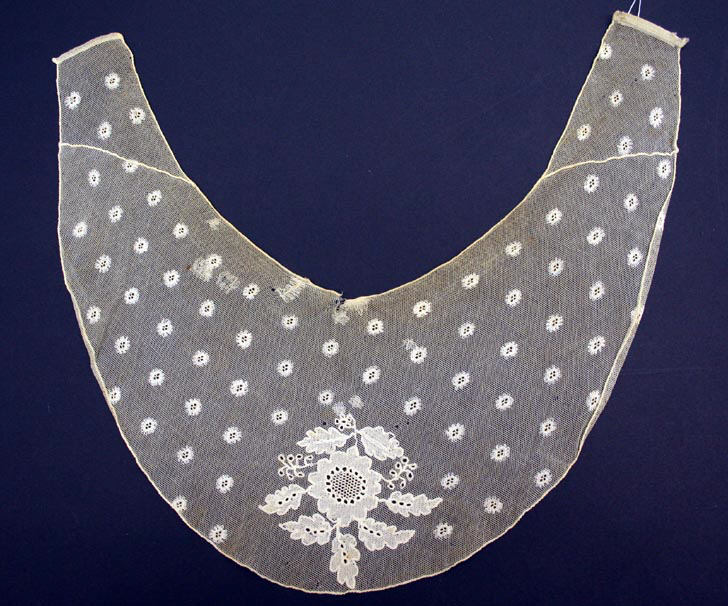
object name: collar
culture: american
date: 1700-1939